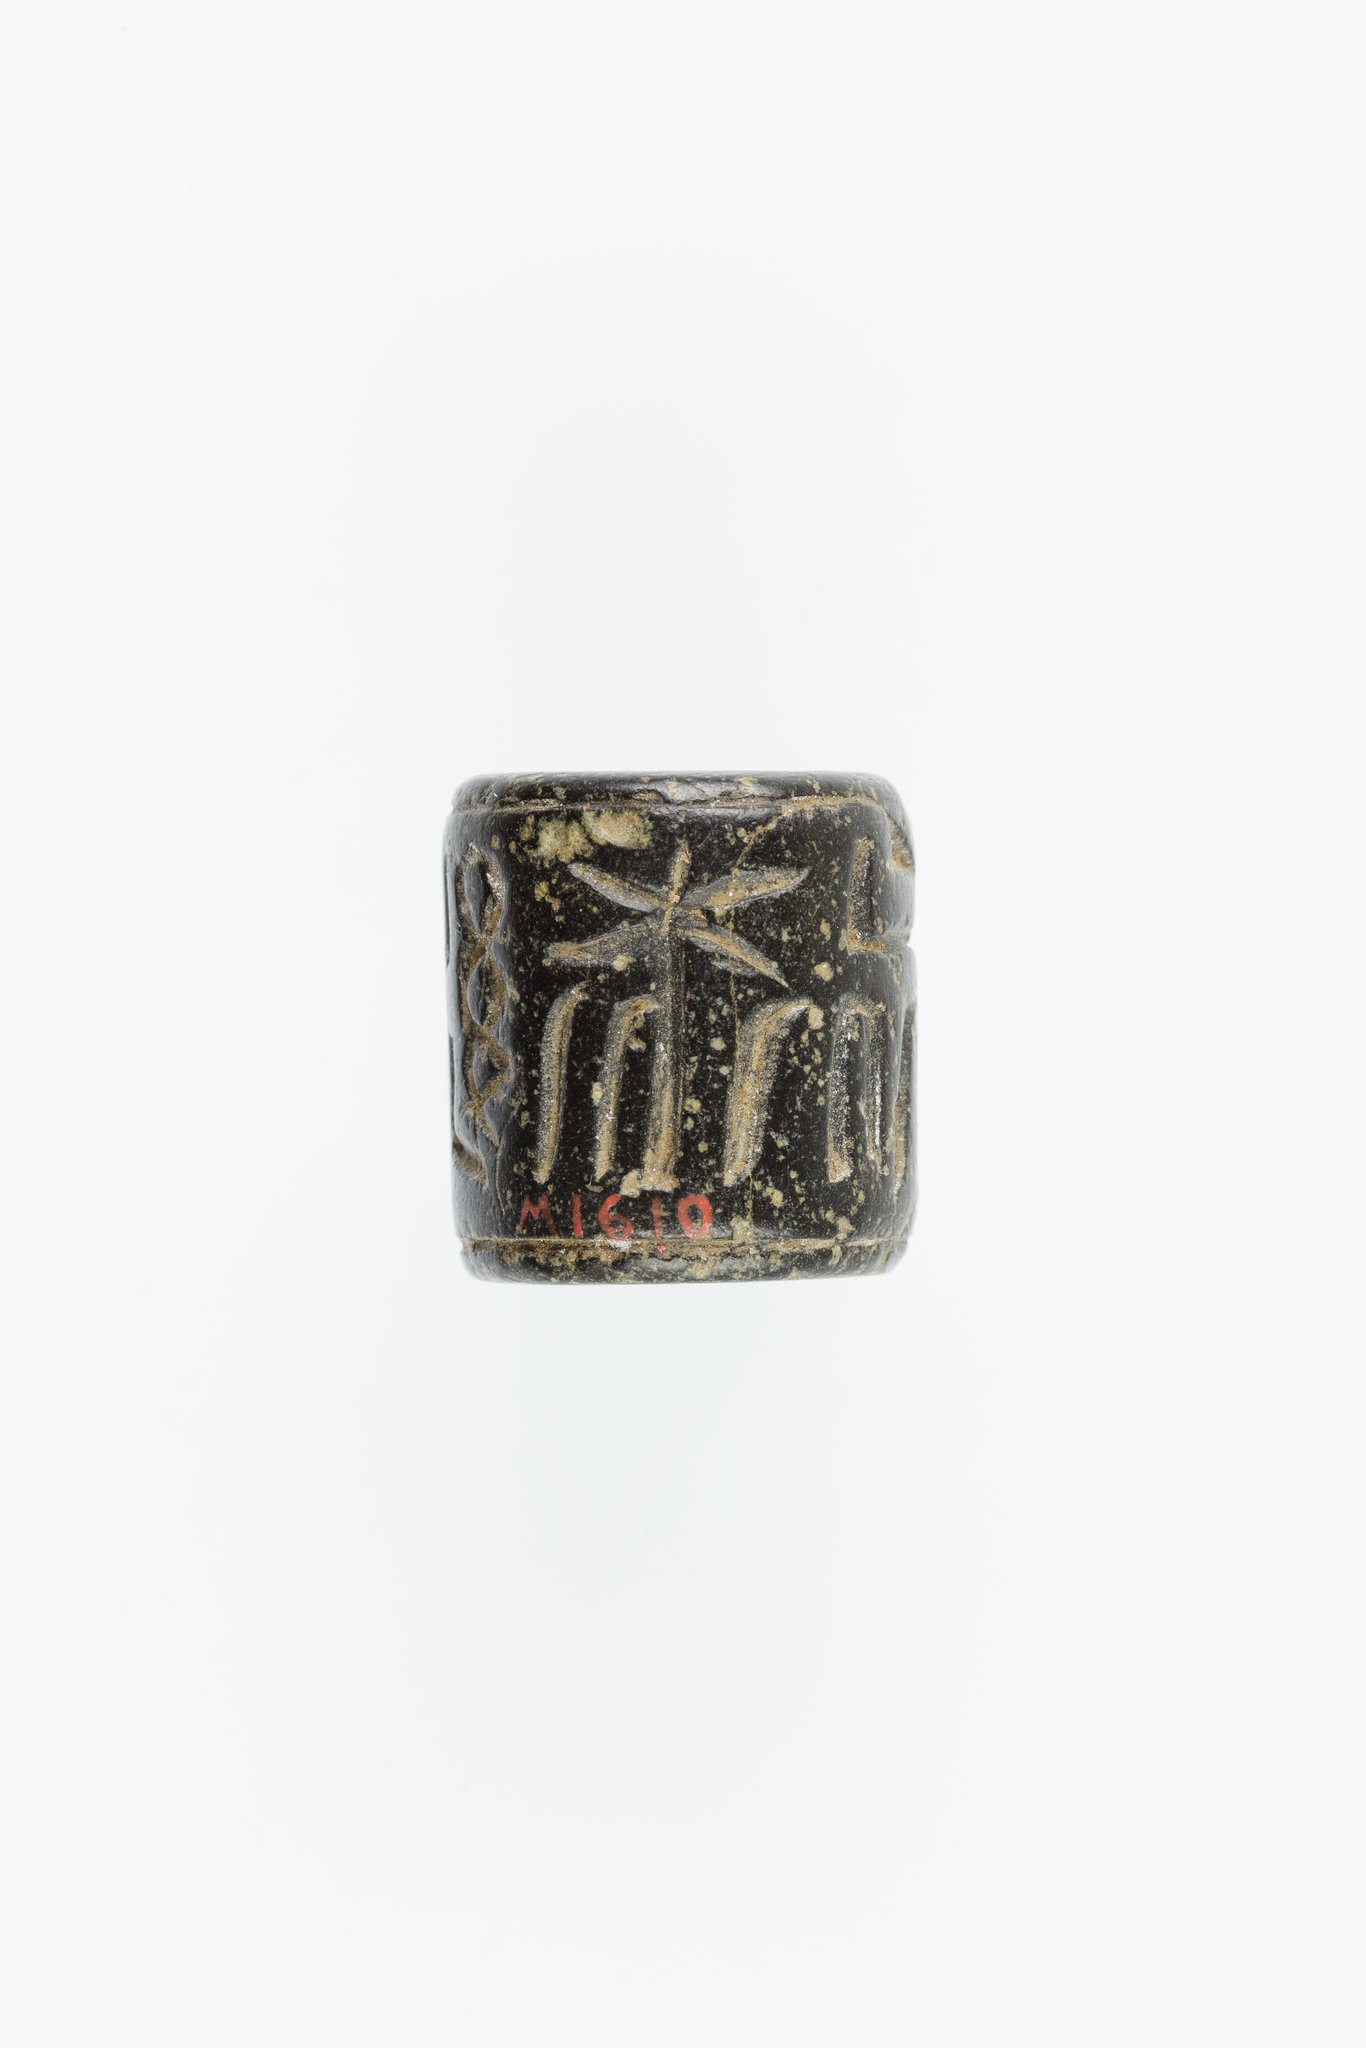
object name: cylinder seal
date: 2960-2649 BCE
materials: stone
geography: egypt